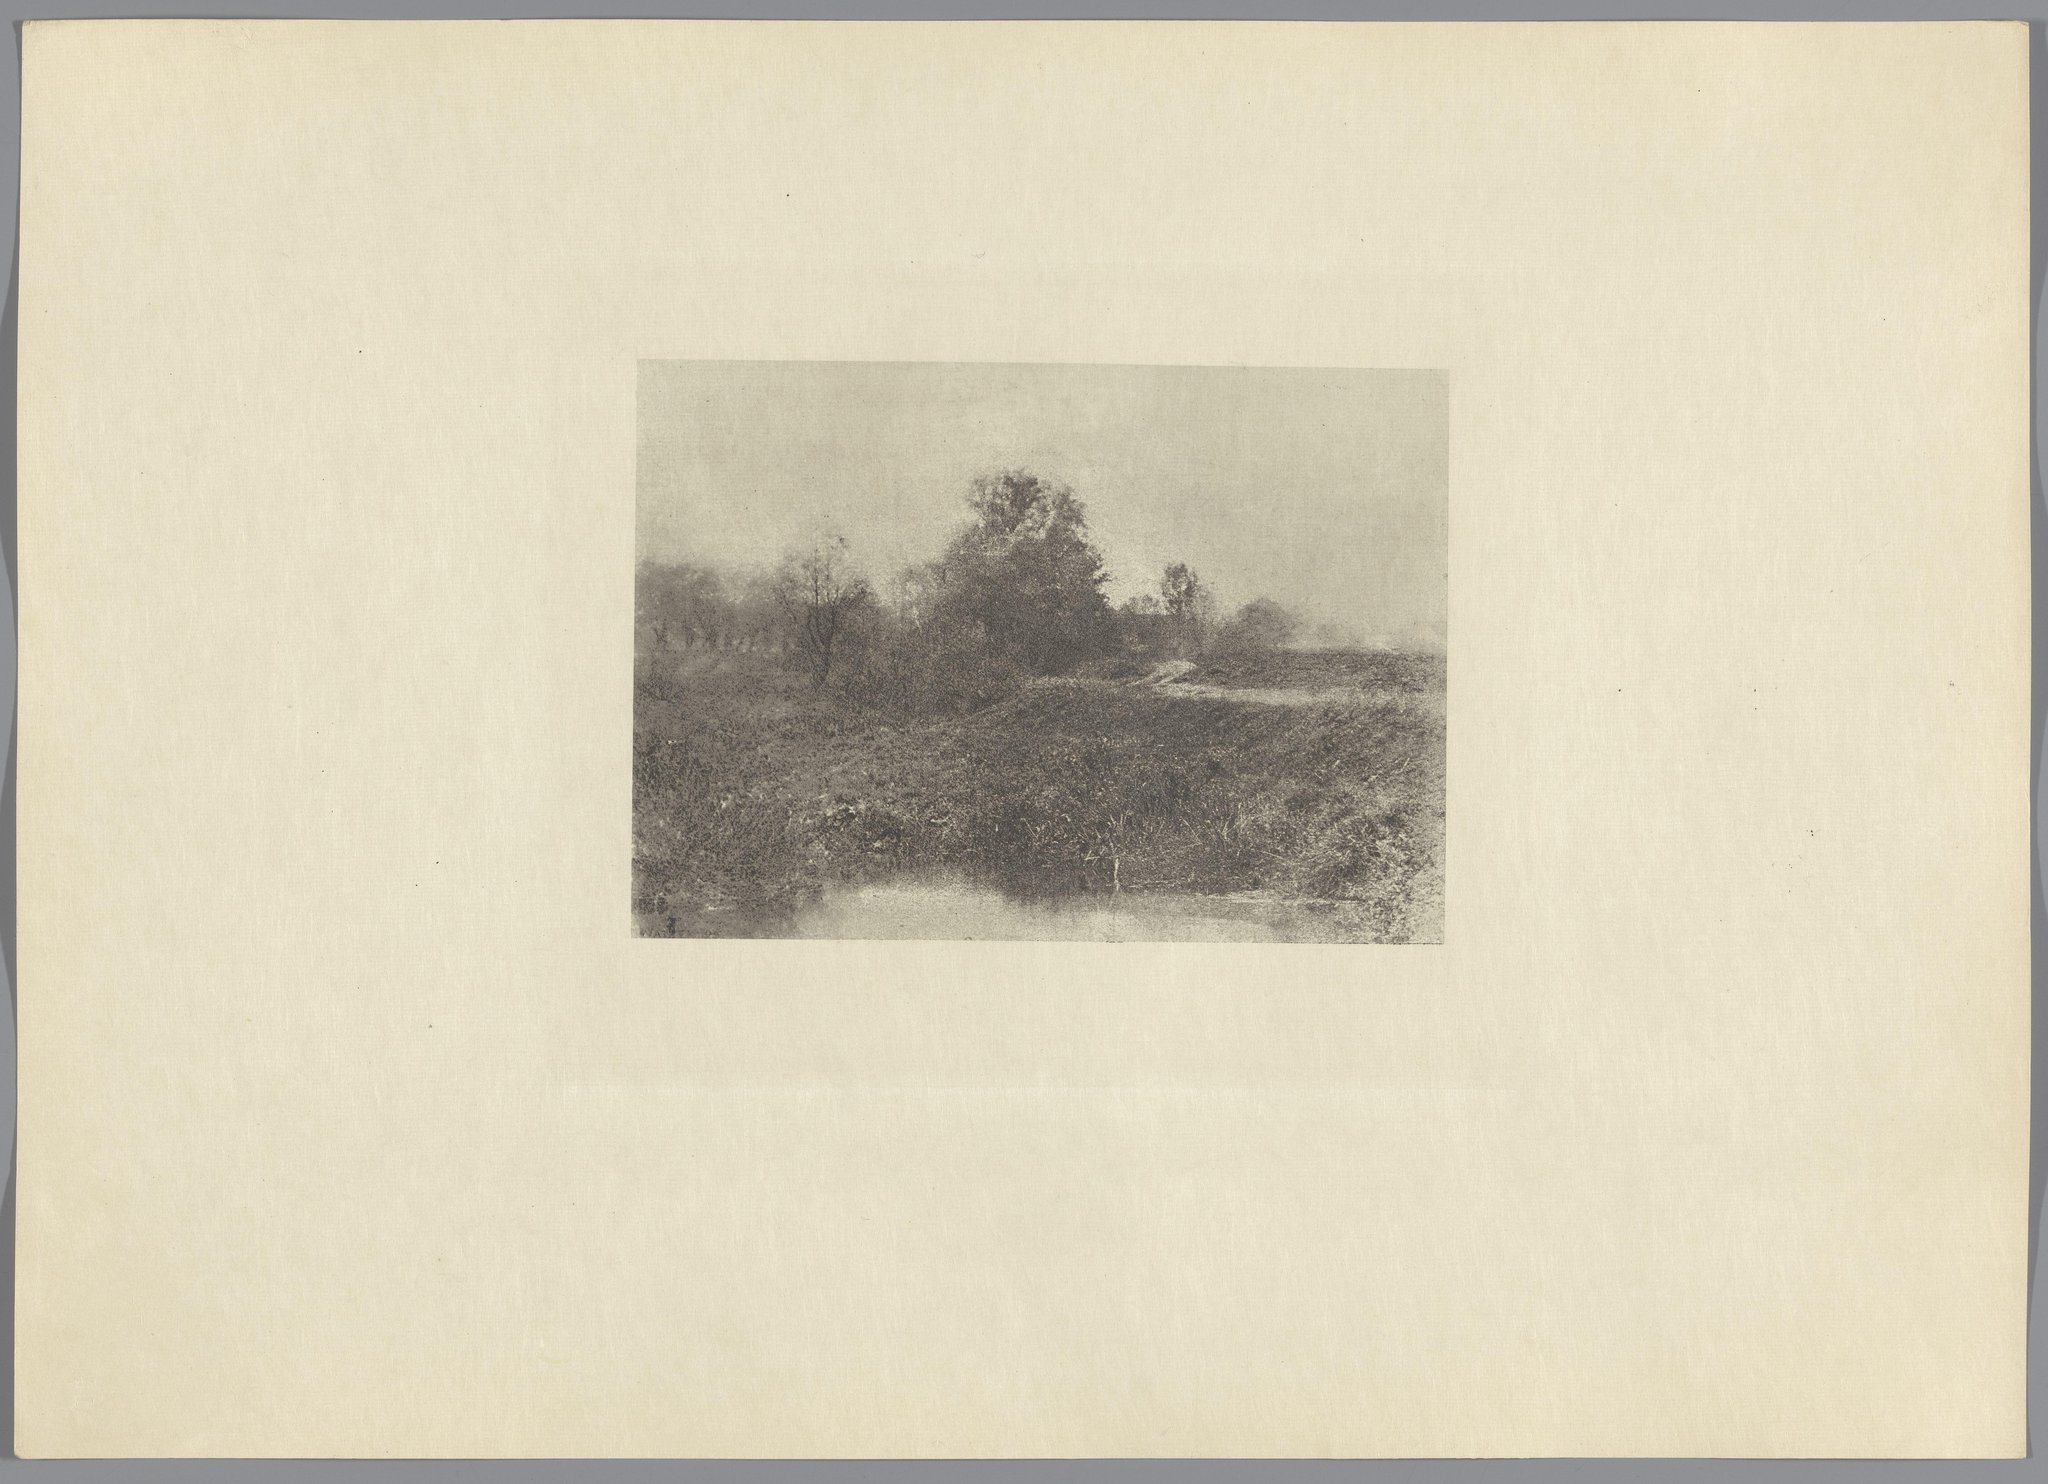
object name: photomechanical print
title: Herfstlandschap in de avond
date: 1891-1896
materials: paper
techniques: photoaquatint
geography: paris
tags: evening, shrubs, autumn landscape; landscape symbolizing autumn (the four seasons of the year)